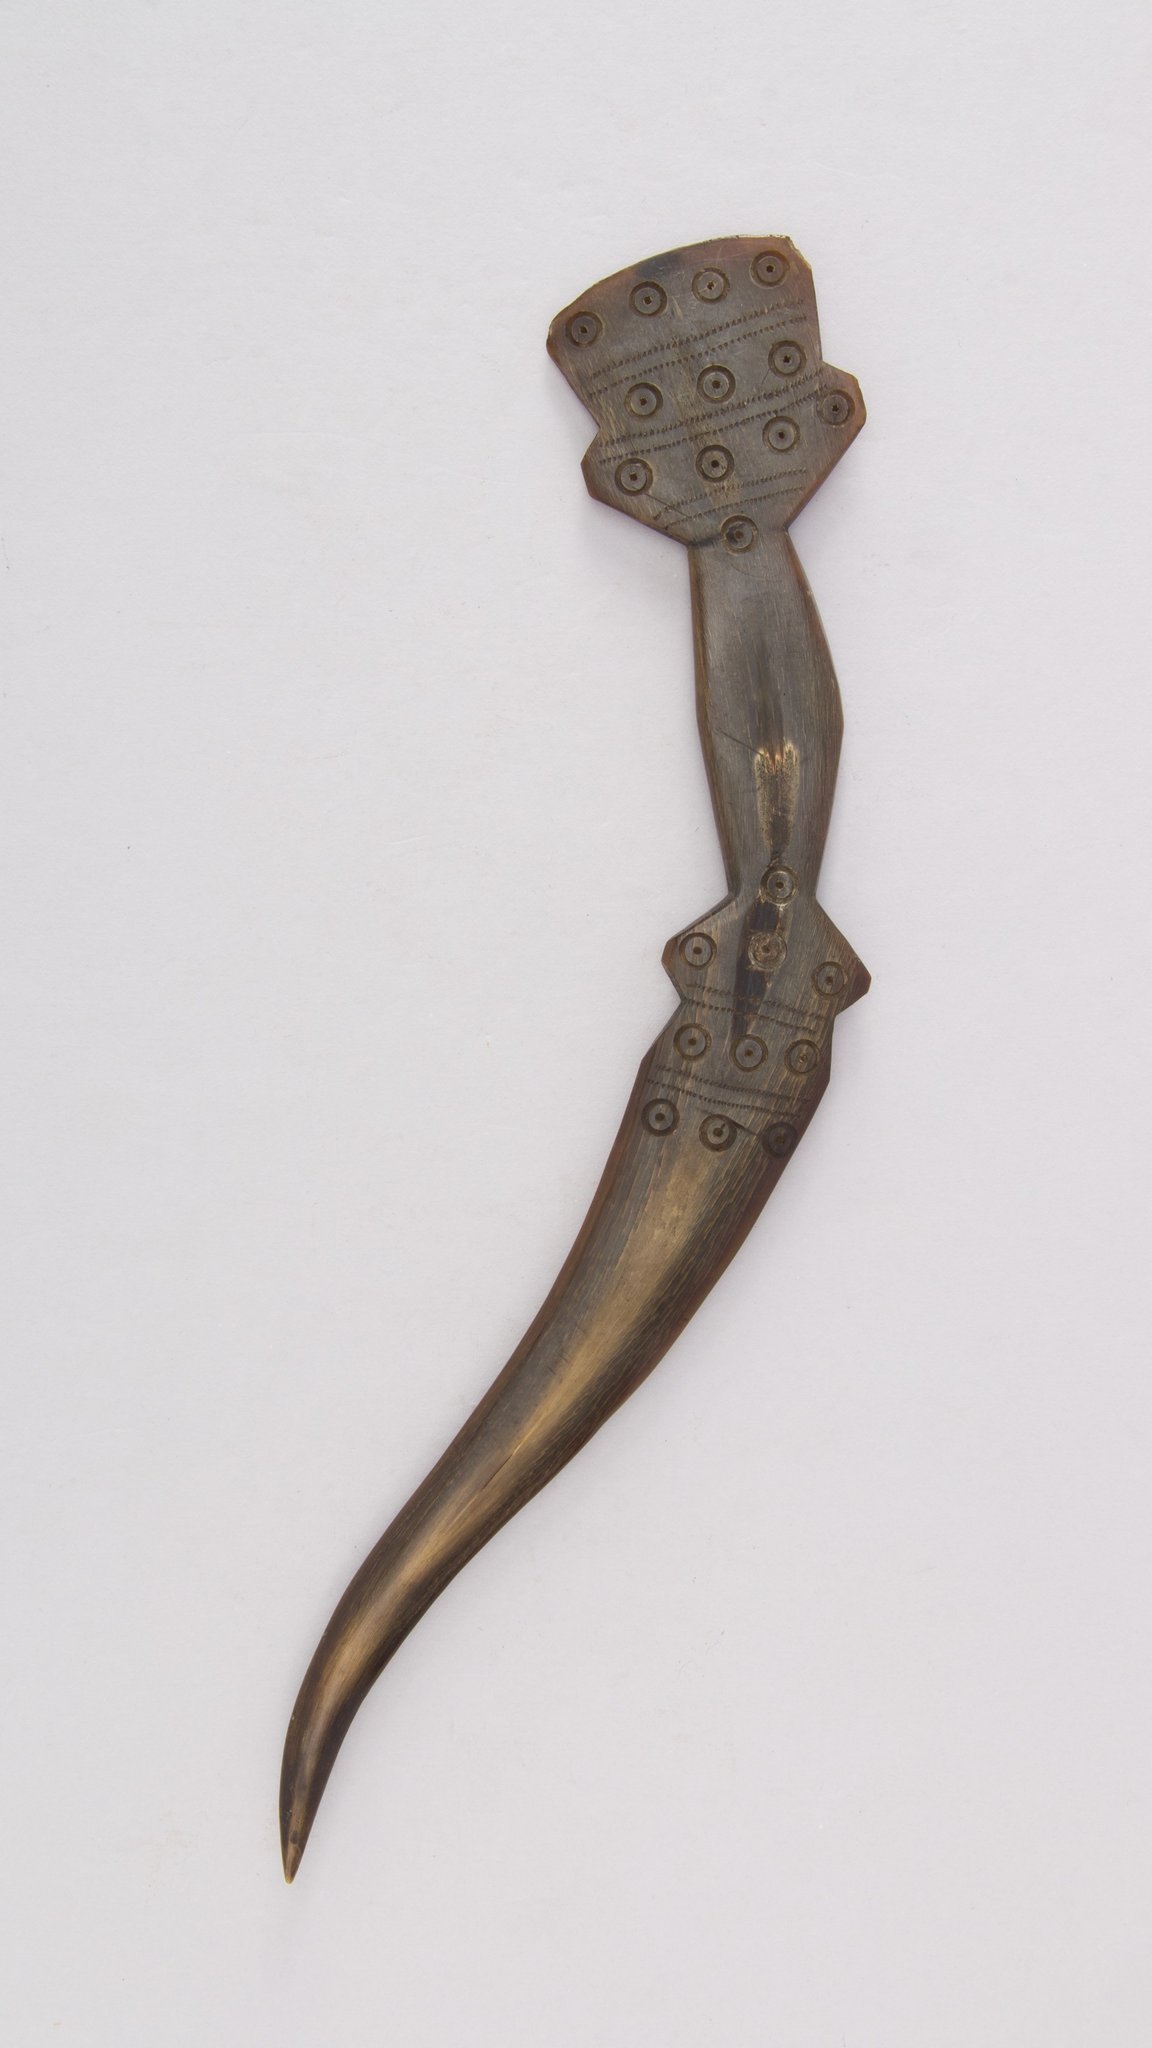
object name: dagger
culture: indian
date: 1701-1900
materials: horn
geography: central india